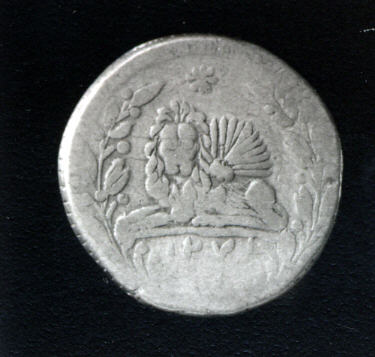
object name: coin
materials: copper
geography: iran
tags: lions